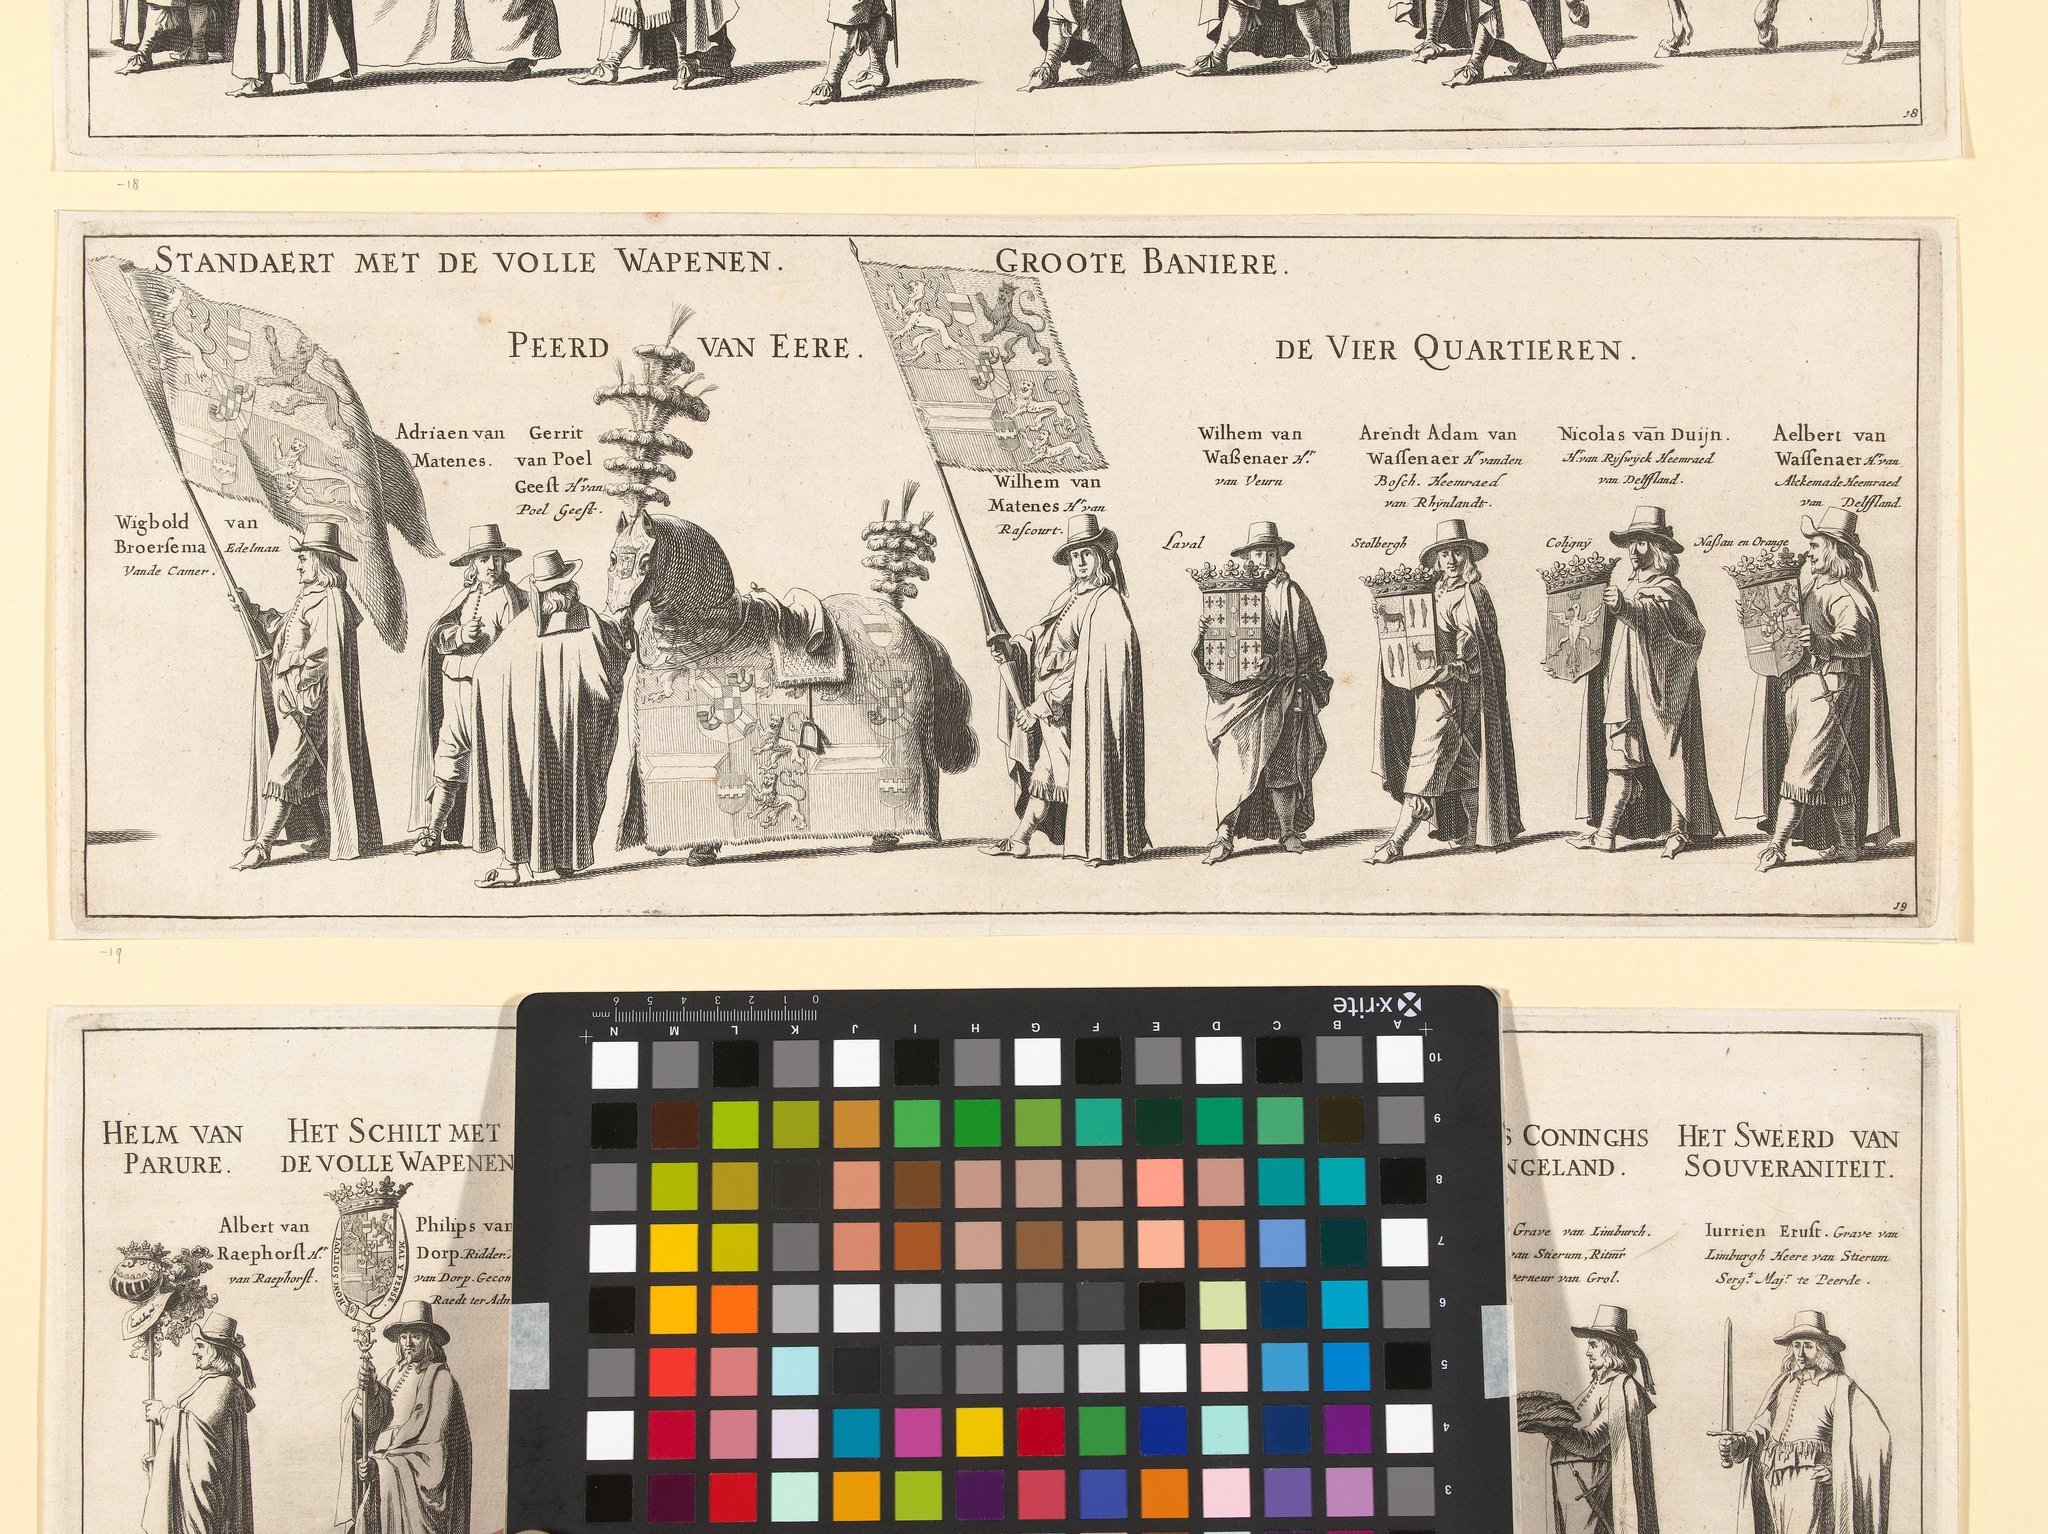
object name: print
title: De begrafenisstoet van stadhouder Frederik Hendrik te 's-Gravenhage in 1647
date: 1647-1651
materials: paper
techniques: etching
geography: amsterdam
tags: frederick henry (prince of orange), cortege, funeral procession, the hague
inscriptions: collector's mark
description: De begrafenisstoet van stadhouder Frederik Hendrik te 's-Gravenhage op 10 mei 1647. Plaat nr. 19 met een deel van de stoet met vaandeldragers, het paard van eer en wapendragers, boven de personen staan hun naam en functie. Onderdeel van een serie van 30 platen en 20 tekstbladen, bedoeld om aan elkaar geplakt te worden.